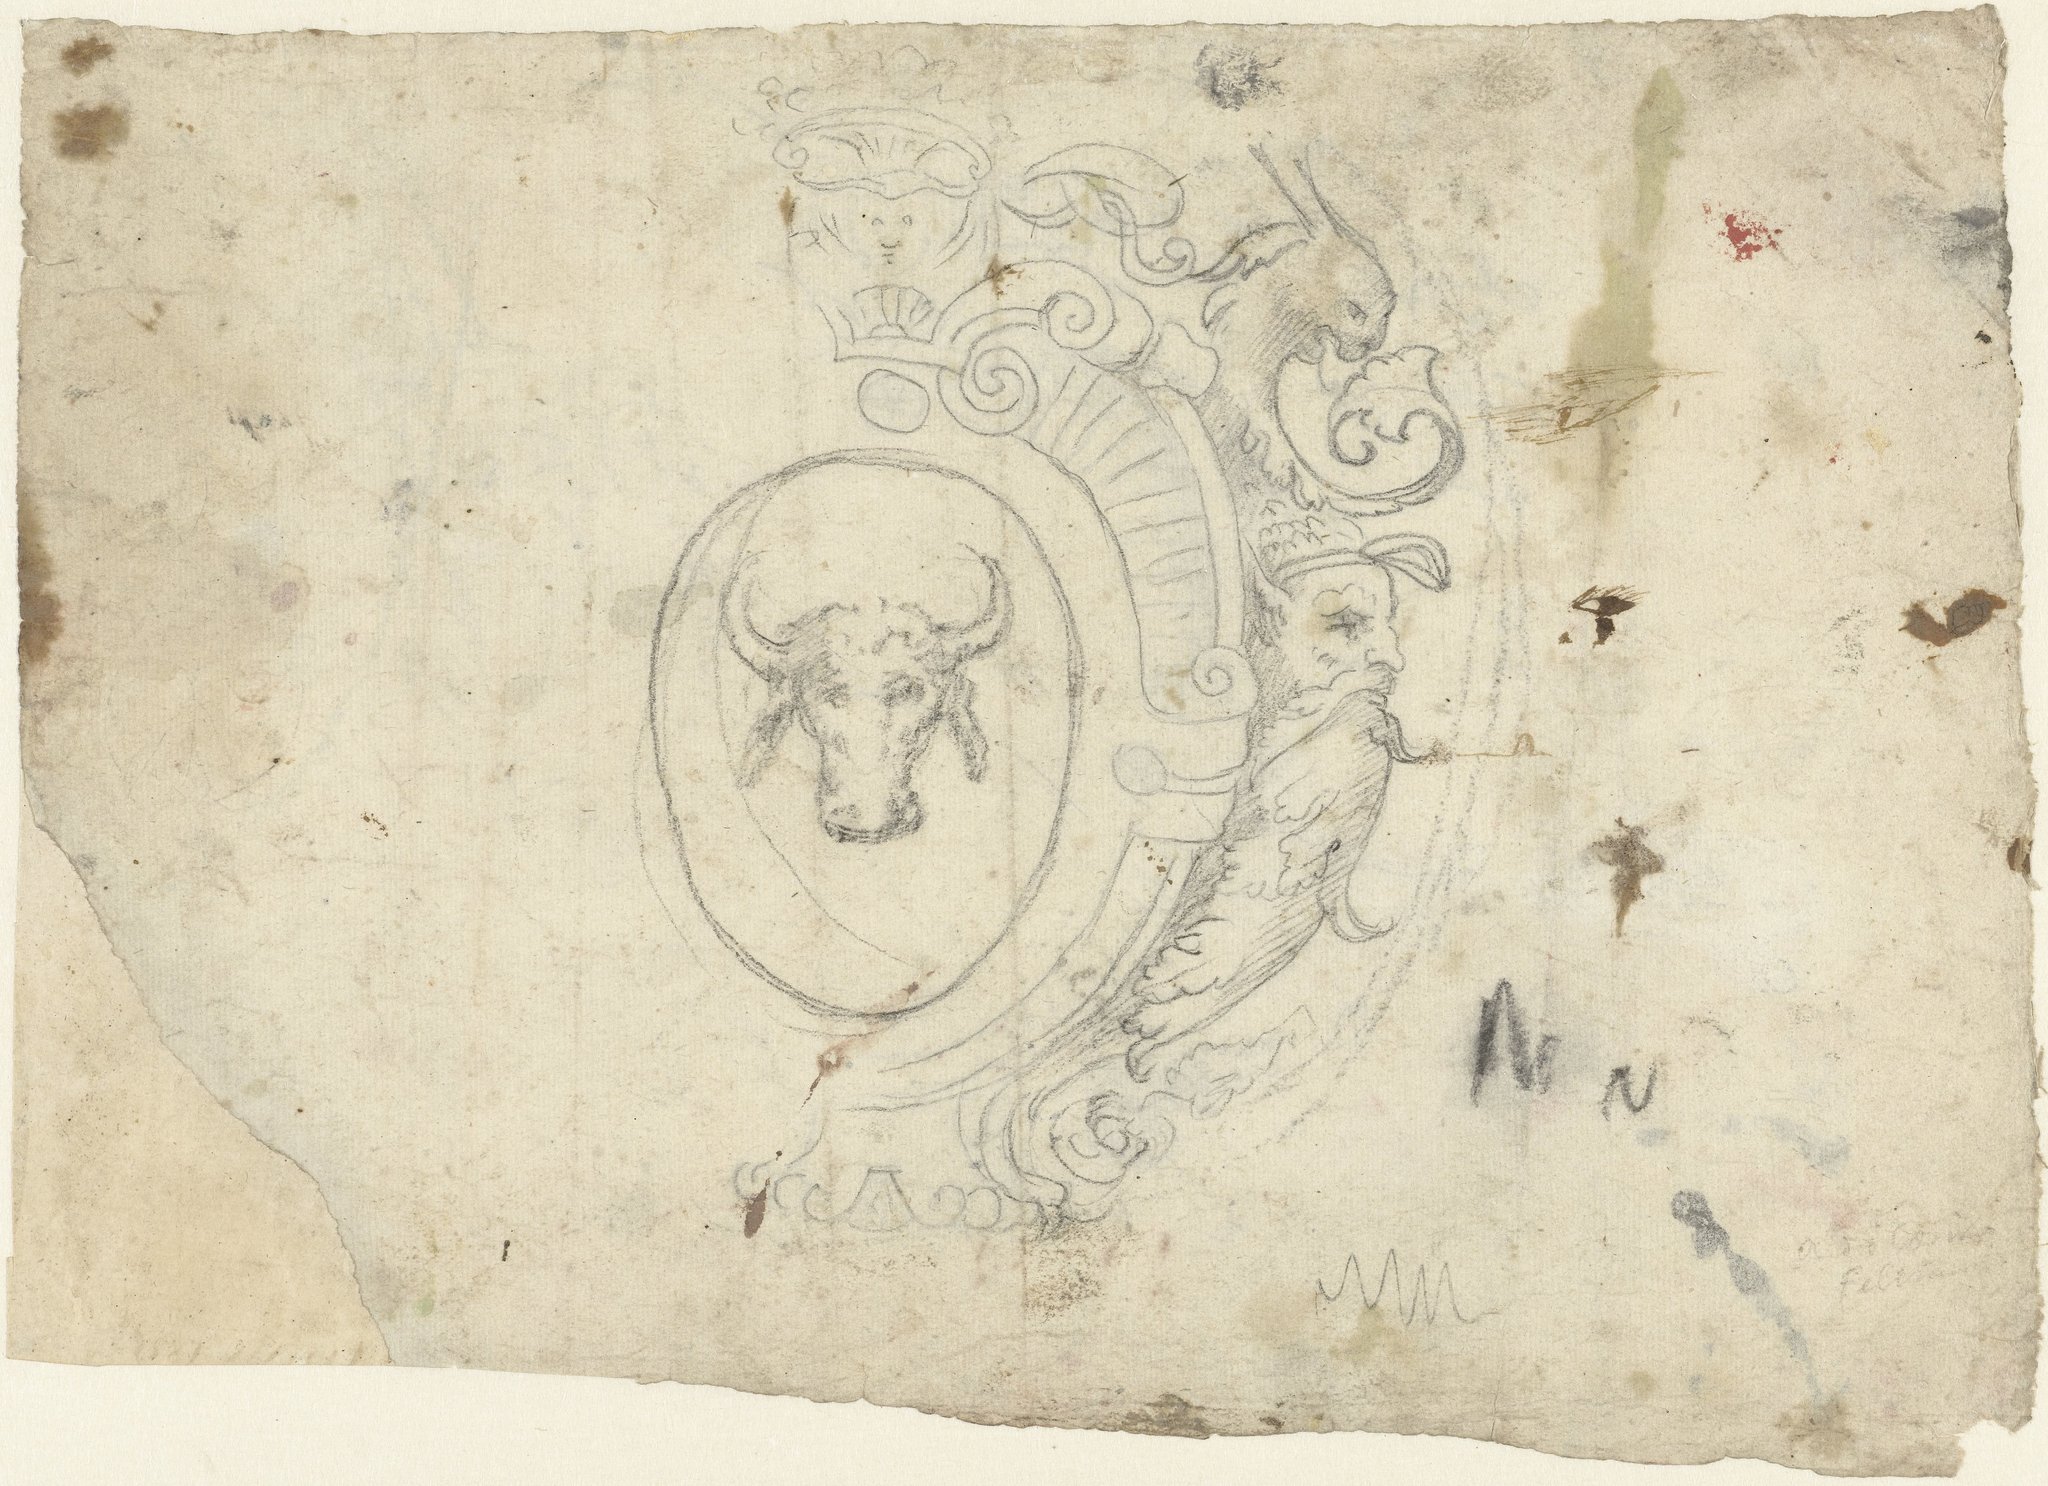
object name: drawing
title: Ontwerp voor een lijst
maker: andrea di cosimo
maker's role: draughtsman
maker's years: 1477-1548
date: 1487-1548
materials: chalk, paper